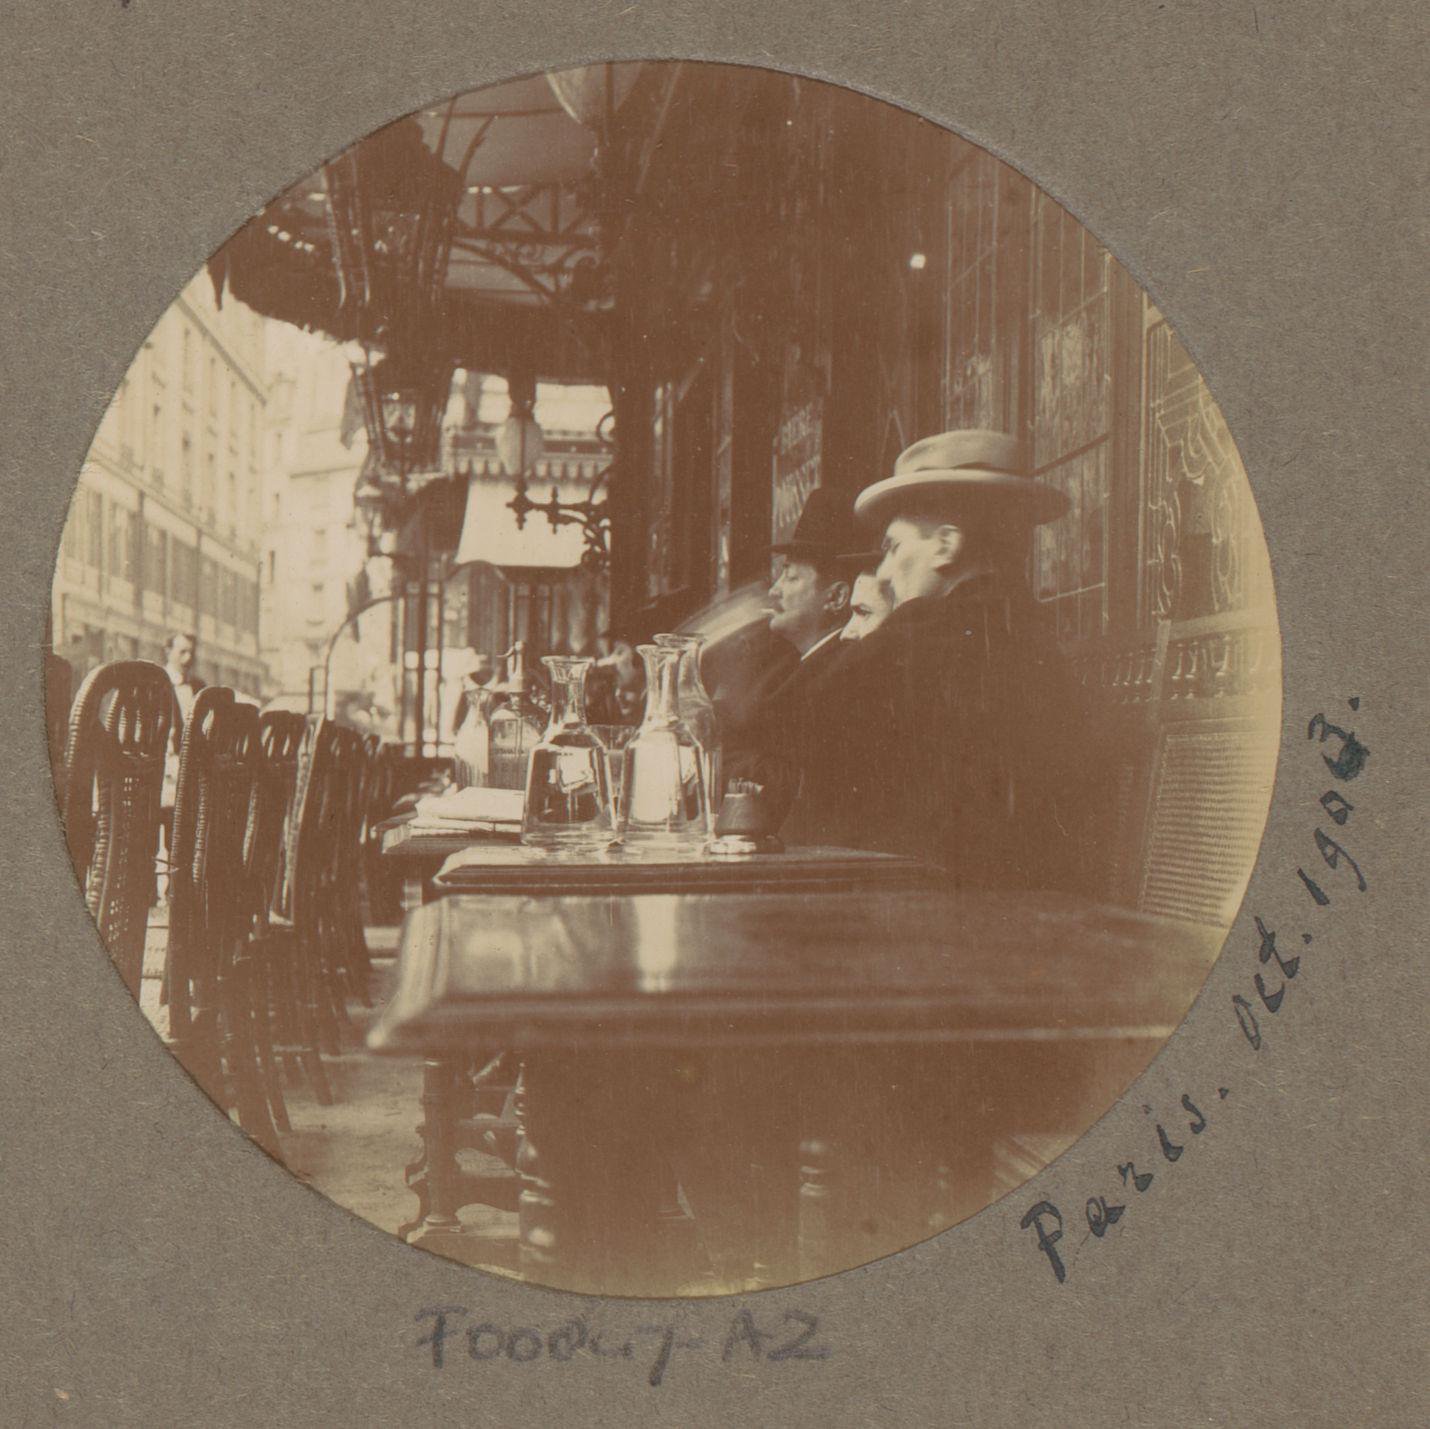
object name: album leaf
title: Mannen op een terras in Parijs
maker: Anonymous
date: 1903-1910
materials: cardboard, paper, photographic support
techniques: gelatin silver print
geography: paris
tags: pavement, terrace in front of inn or restaurant, street (+ city(-scape) with figures, staffage), paris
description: Onderdeel van Reisalbum van een Nederlandse familie met bezienswaardigheden in Europa, Egypte en New York.